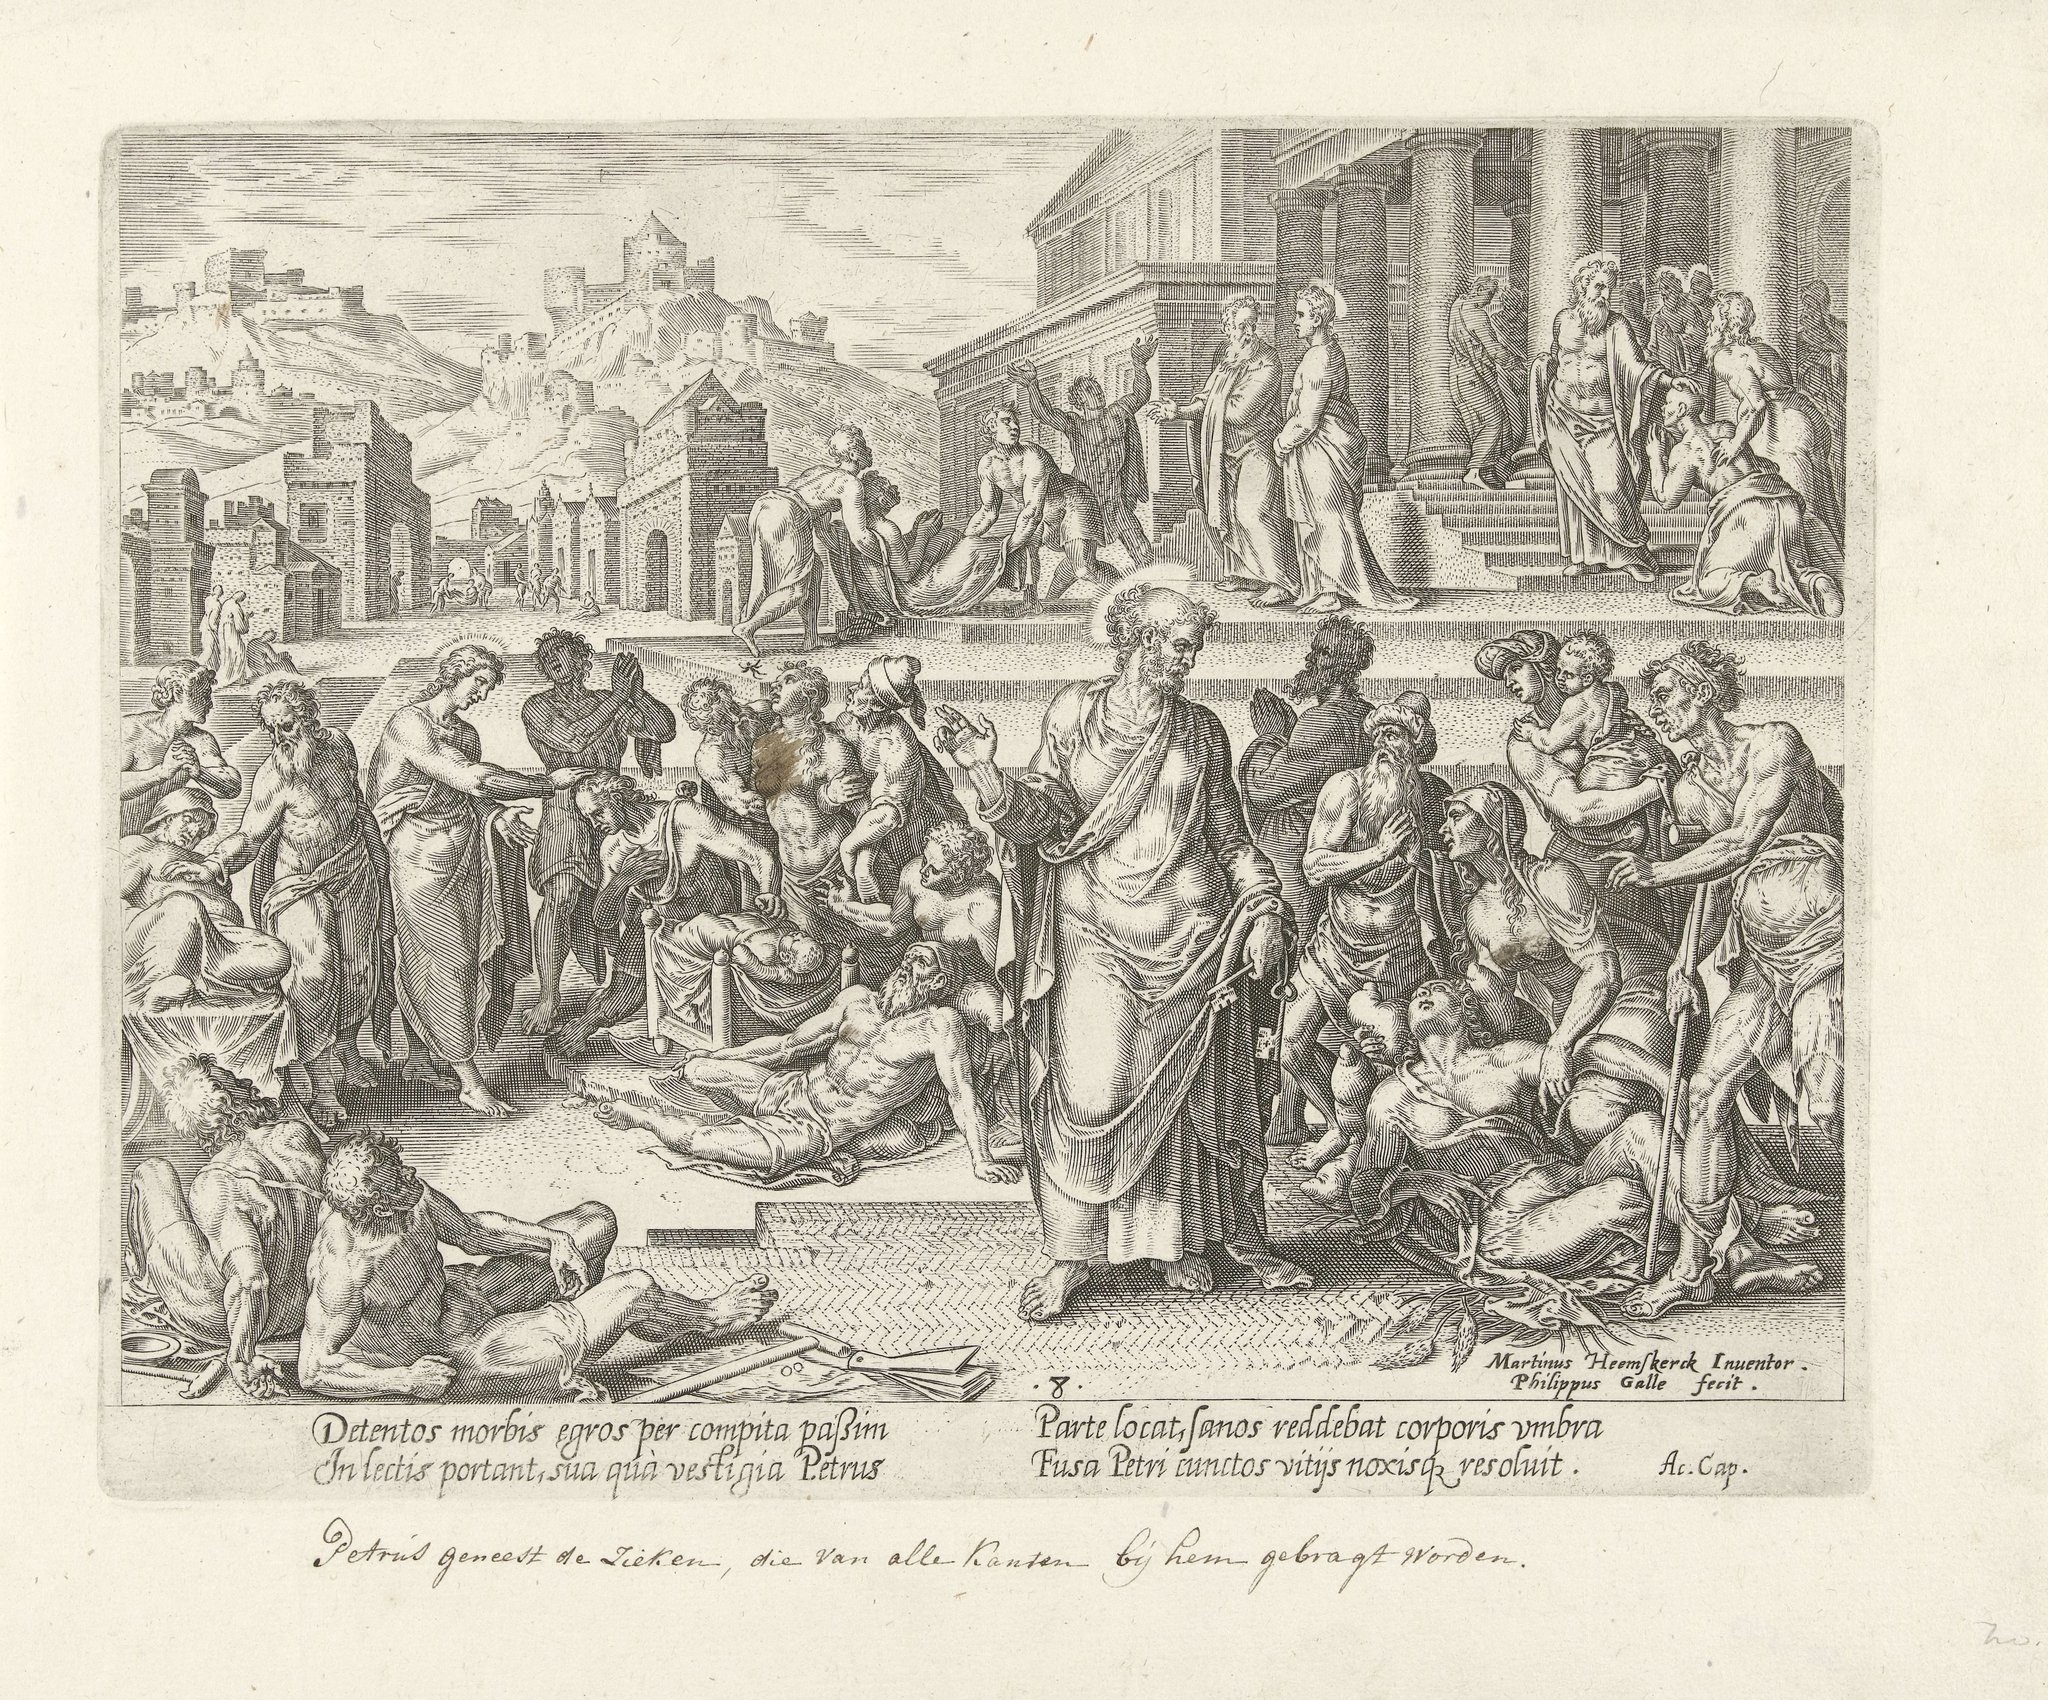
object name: print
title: Acta Apostolorum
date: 1582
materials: paper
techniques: brush, engraving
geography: antwerp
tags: a multitude of the sick healed by peter and other disciples (acts 5:12-16), sick people brought into the streets, so that peter's shadow might fall on them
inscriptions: collector's mark: Lugt 2228, caption: ‘Petrus geneest de zieken, die van alle kanten bij hem gebragt worden’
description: Centraal in de voorgrond de apostel Petrus. Rondom hem allemaal zieken en bezetenen. Zij hopen dat Petrus' schaduw op hen zal vallen en hen zal genezen. Samen met Petrus genezen de andere apostelen de zieken en drijven zij geesten uit. De prent heeft een Latijns onderschrift en maakt deel uit van een 34-delige serie met als onderwerp de Handelingen van de apostelen.